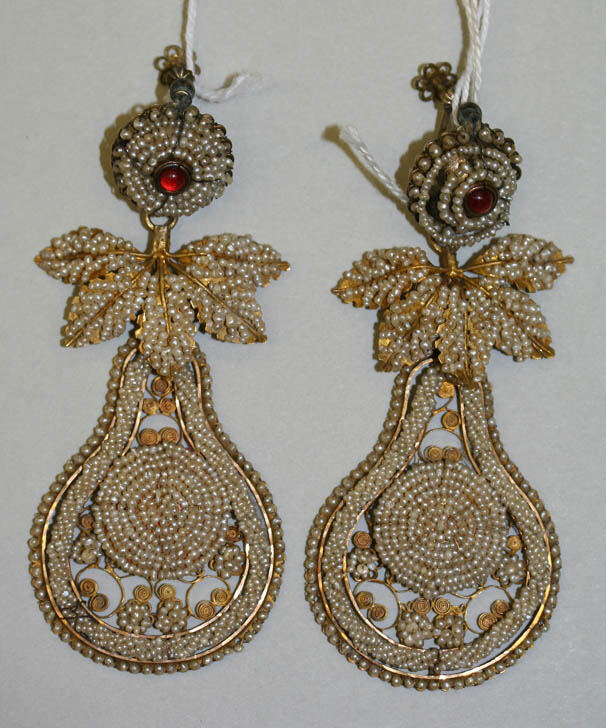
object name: earring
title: Earrings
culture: indian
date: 1810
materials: gold, pearl